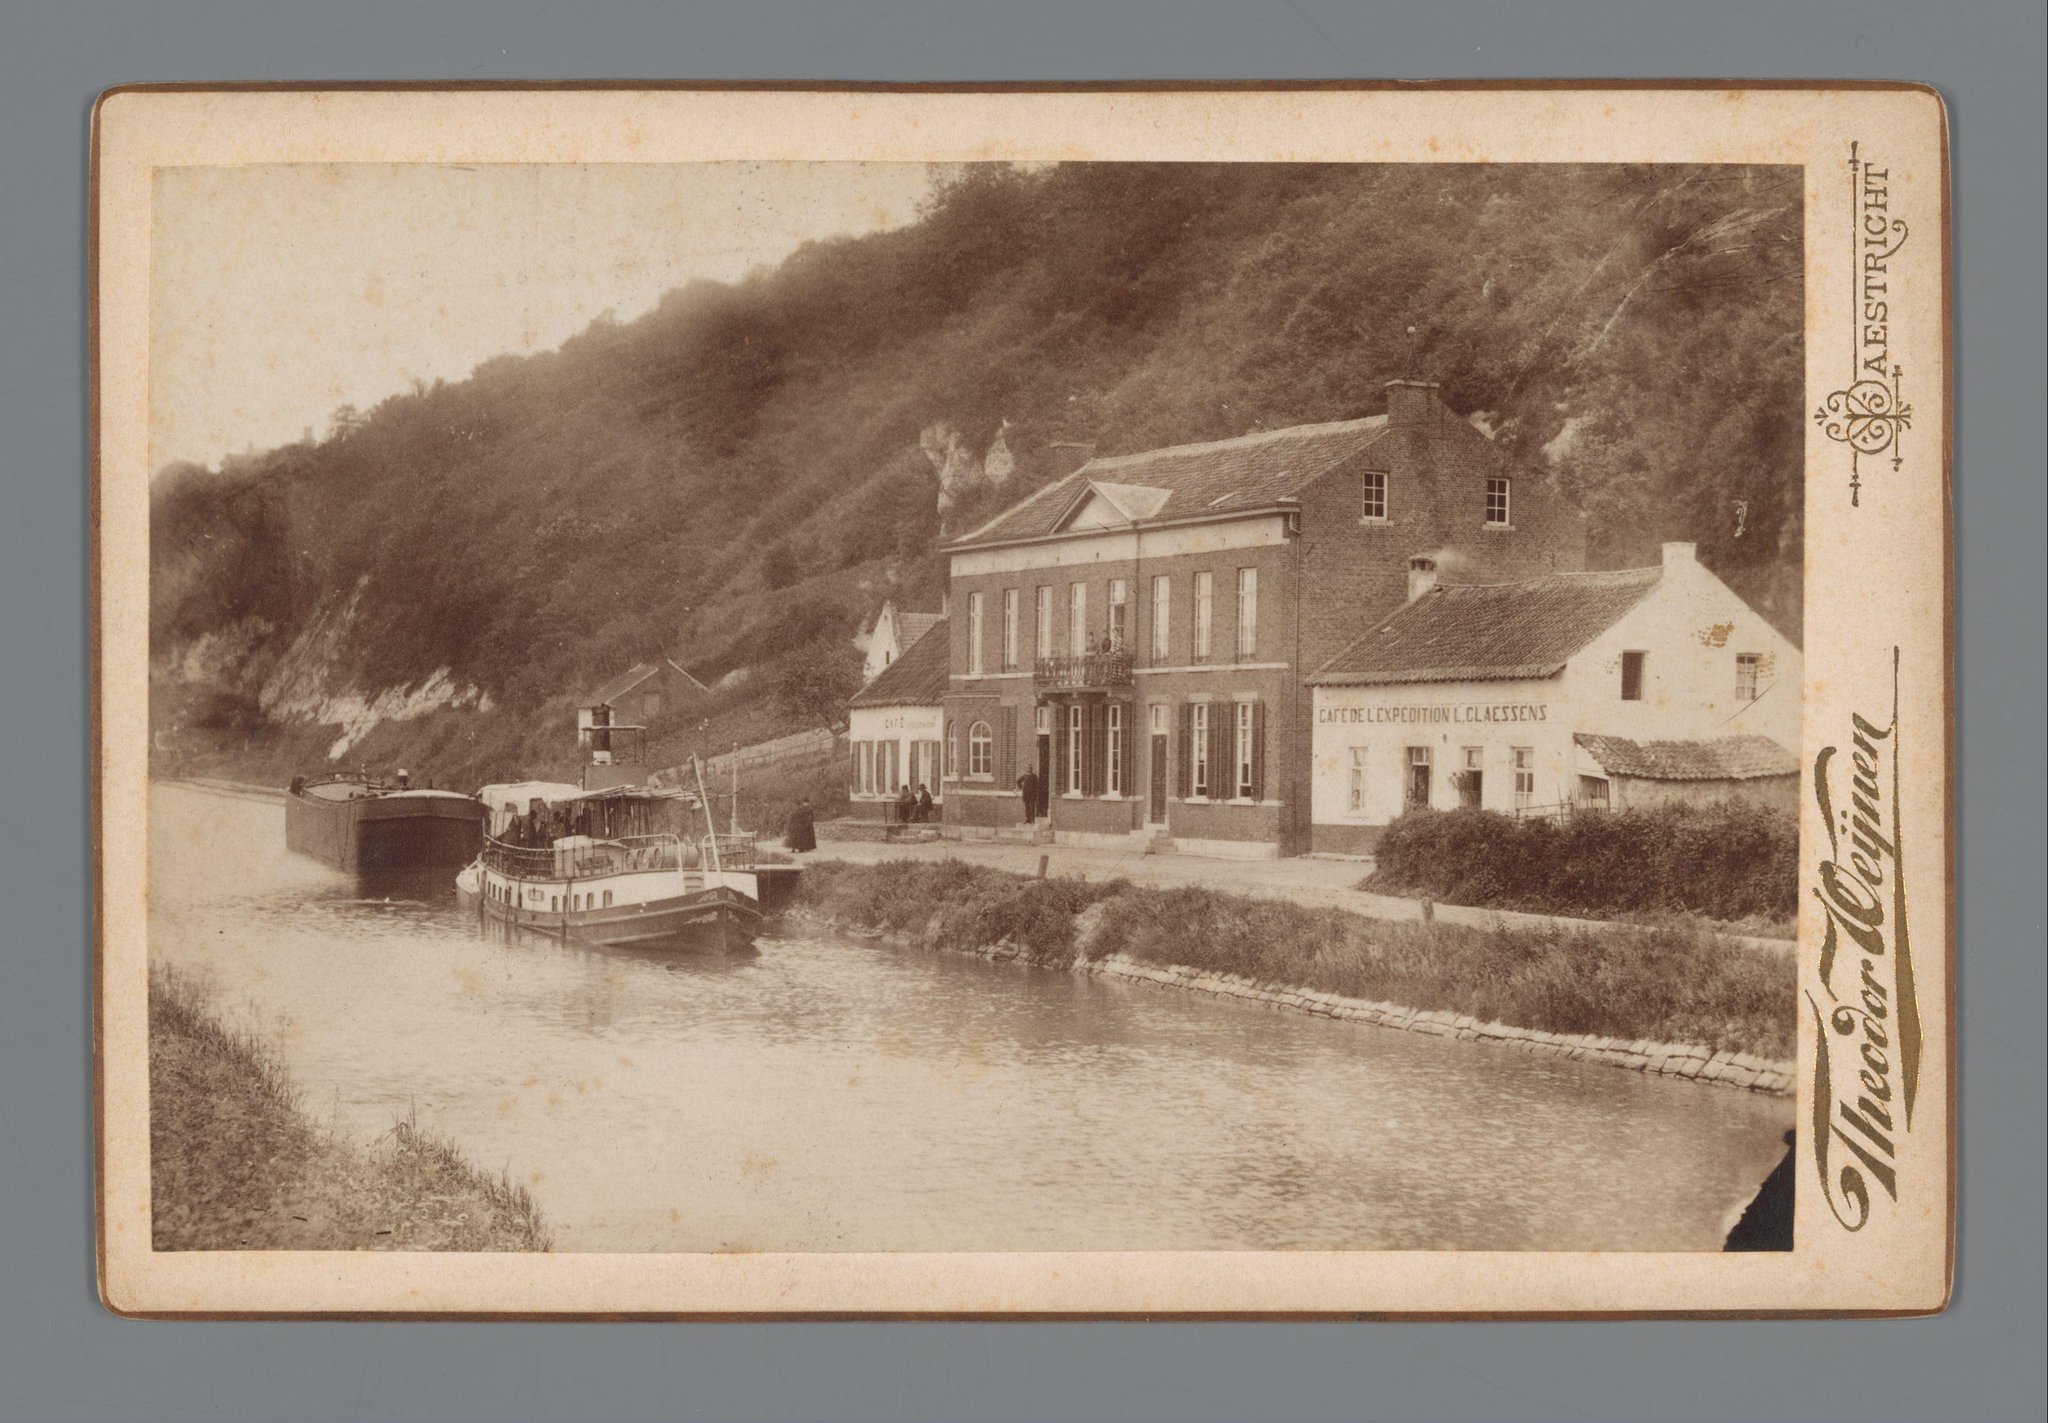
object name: photograph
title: Douanepost aan het kanaal Luik-Maastricht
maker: théodor weijnen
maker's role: fotograaf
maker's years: 1835-1904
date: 1880-1900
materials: cardboard, photographic support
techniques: albumen print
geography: maastricht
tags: canal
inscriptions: annotation: ‘Holl. Duanepost aan het kanaal/ Luik-Maastricht tusschen/ petit lanaye en Maastricht’, inscription: ‘Theodor Weijnen/ Maestricht’